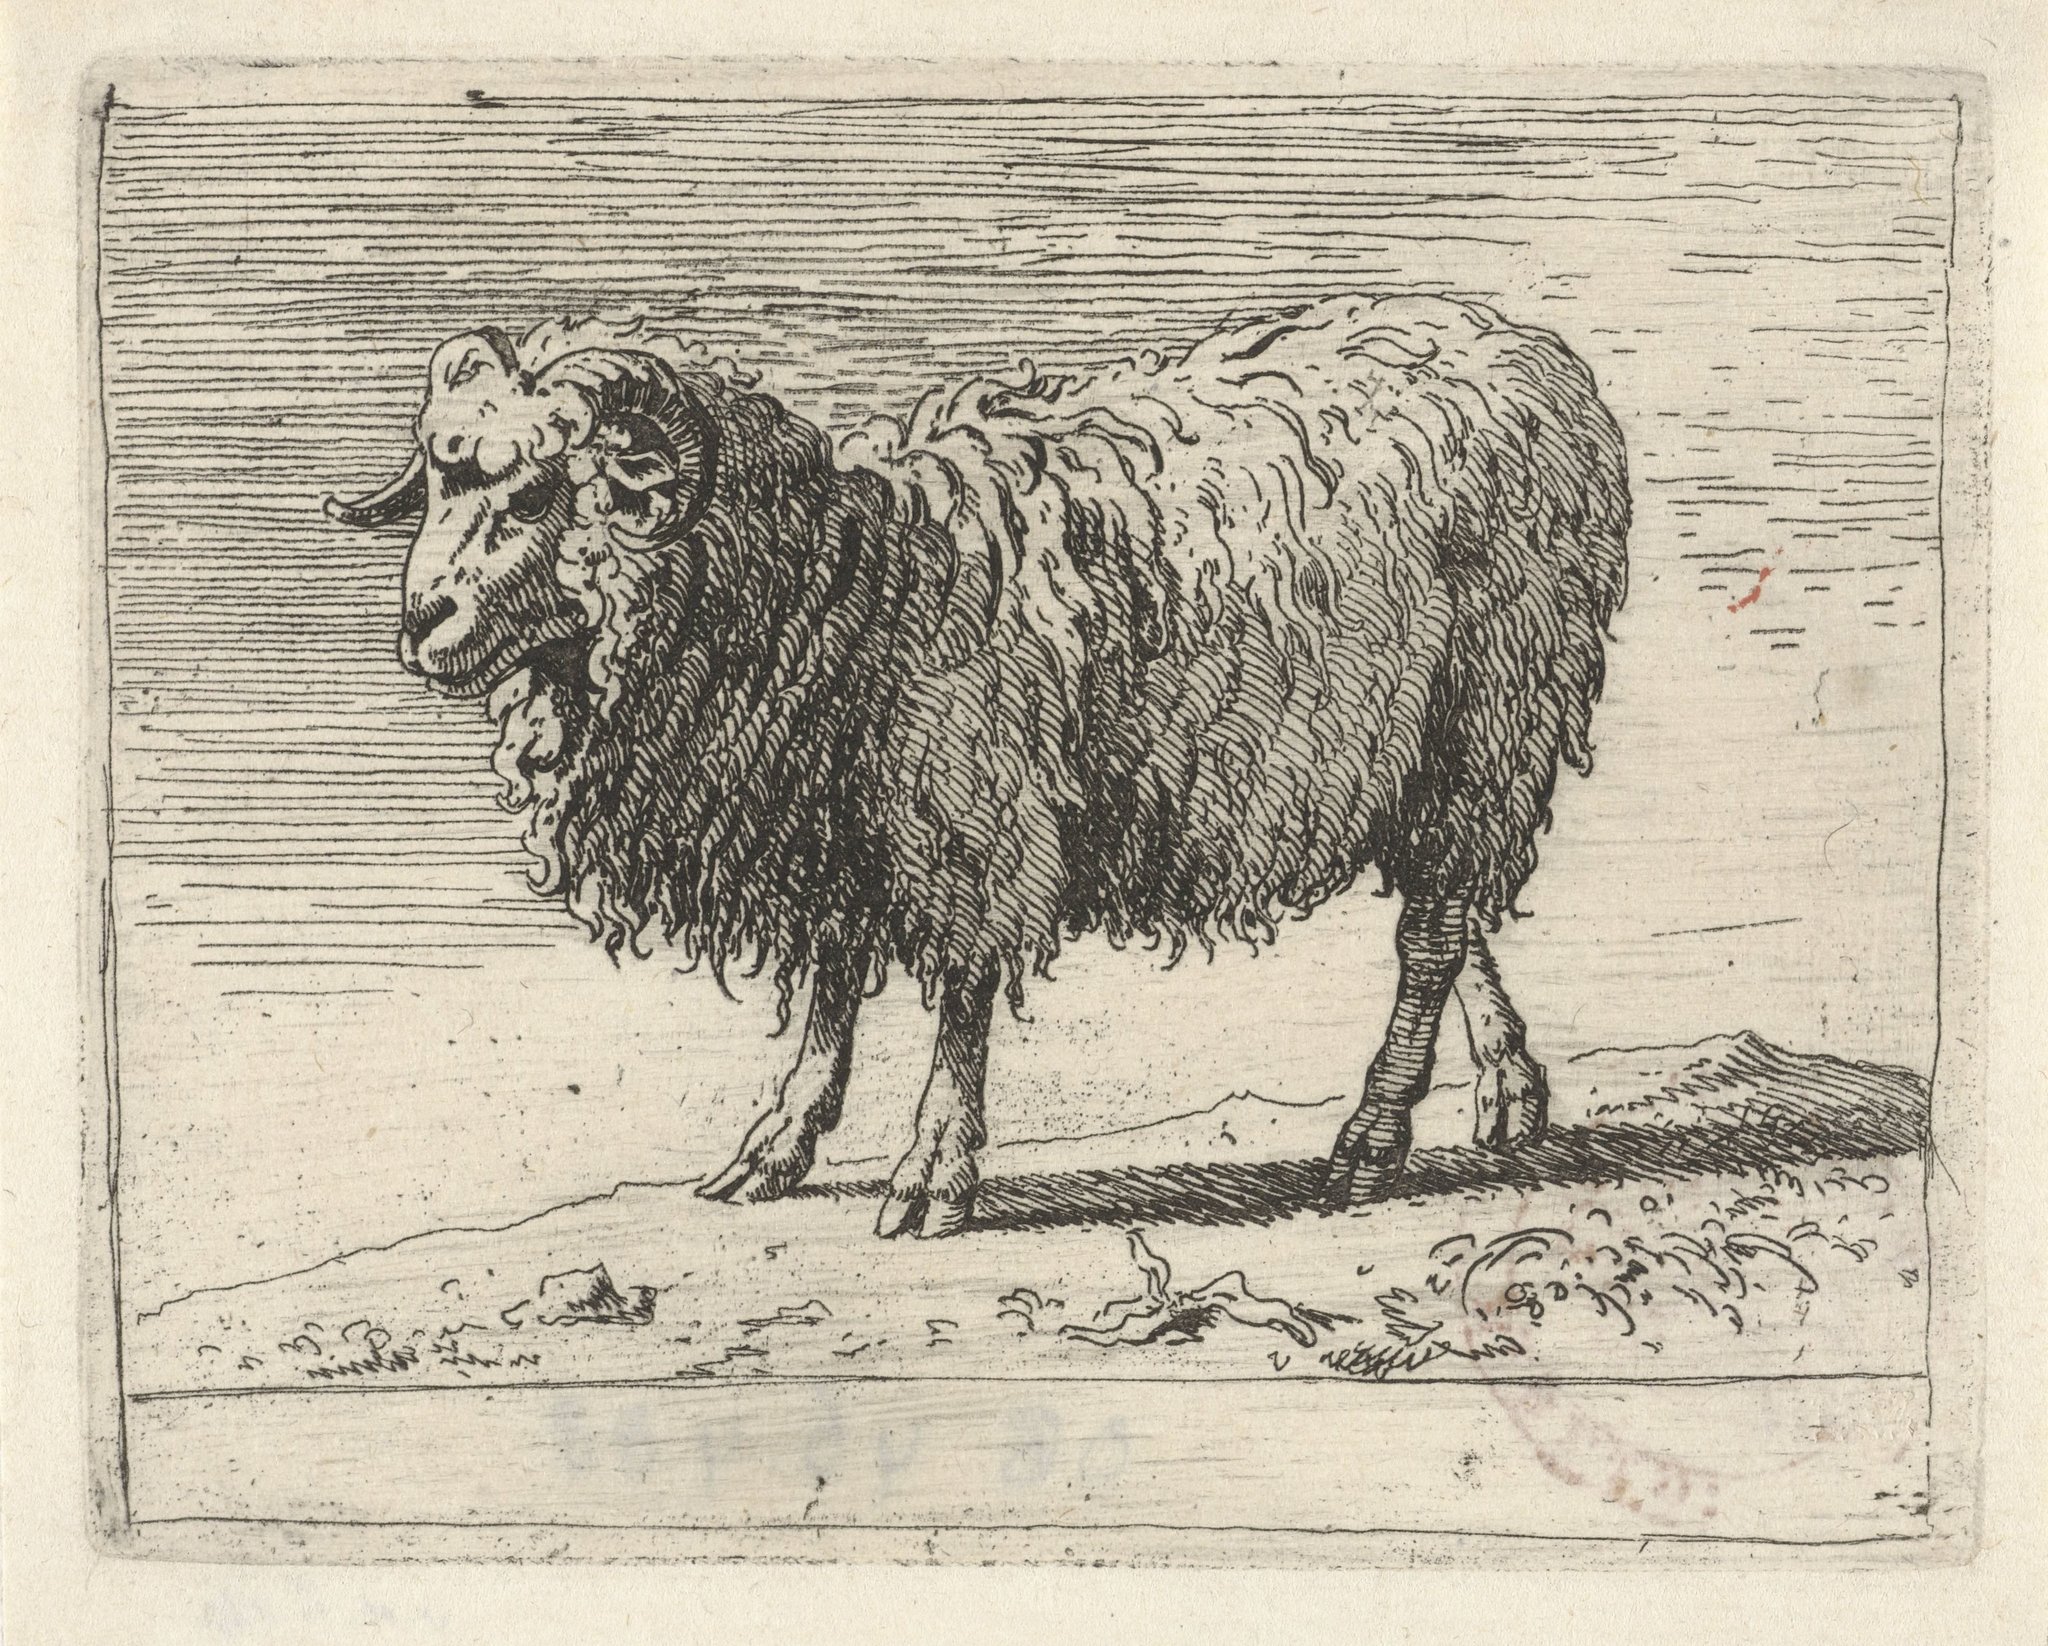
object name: print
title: Ram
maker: govert van der leeuw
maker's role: print maker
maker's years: 1645-1688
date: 1655-1688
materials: paper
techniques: etching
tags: ram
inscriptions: collector's mark: Lugt 240, collector's mark: Lugt 1920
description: Staande ram, naar links. De prent maakt deel uit van een negendelige serie prenten met voorstellingen van diverse dieren.